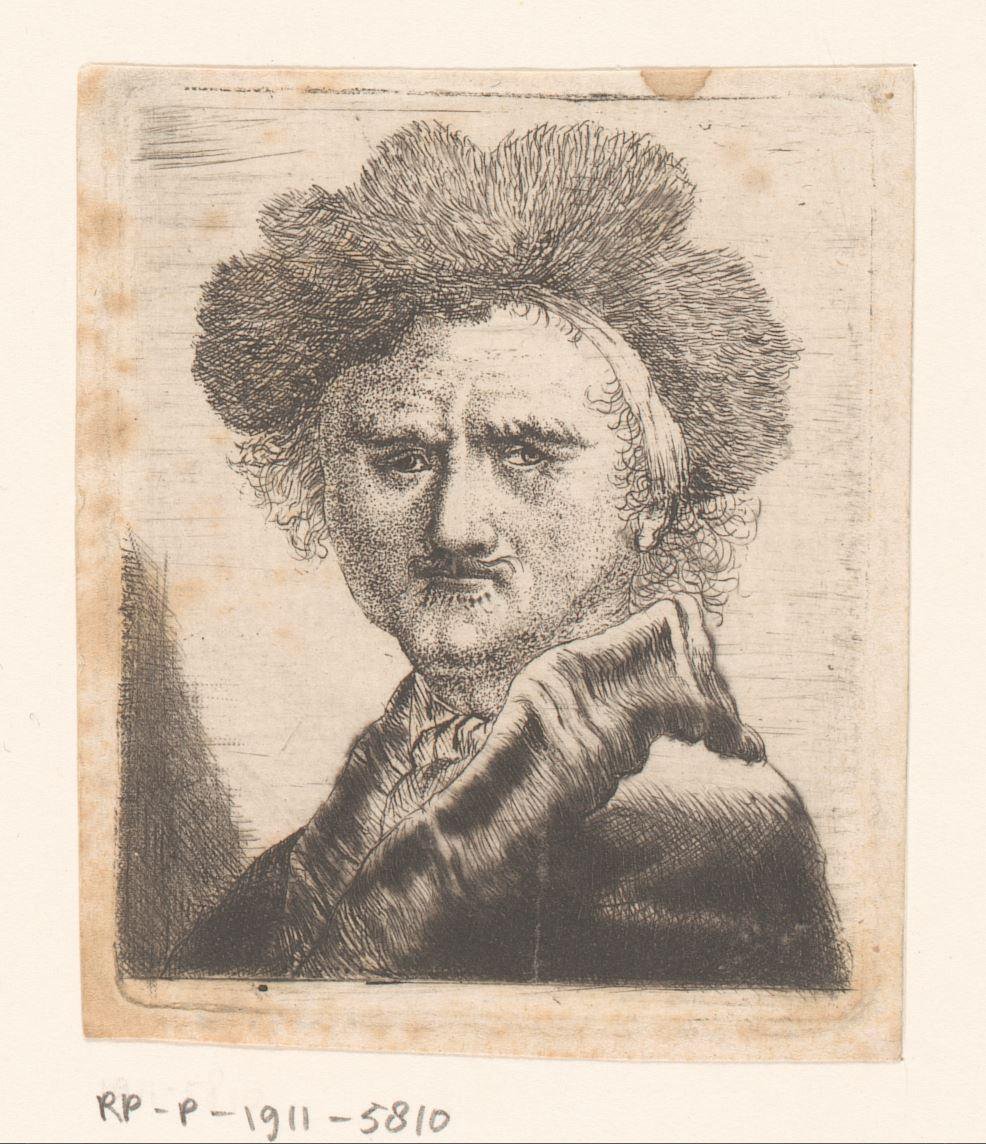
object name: print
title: Buste van een man met bontmuts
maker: sauveur legros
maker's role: print maker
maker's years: 1754-1834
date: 1764-1834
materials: paper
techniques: etching, roulette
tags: adult man, head-gear: cap (+ fur used for clothes)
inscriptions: collector's mark: Lugt 2228